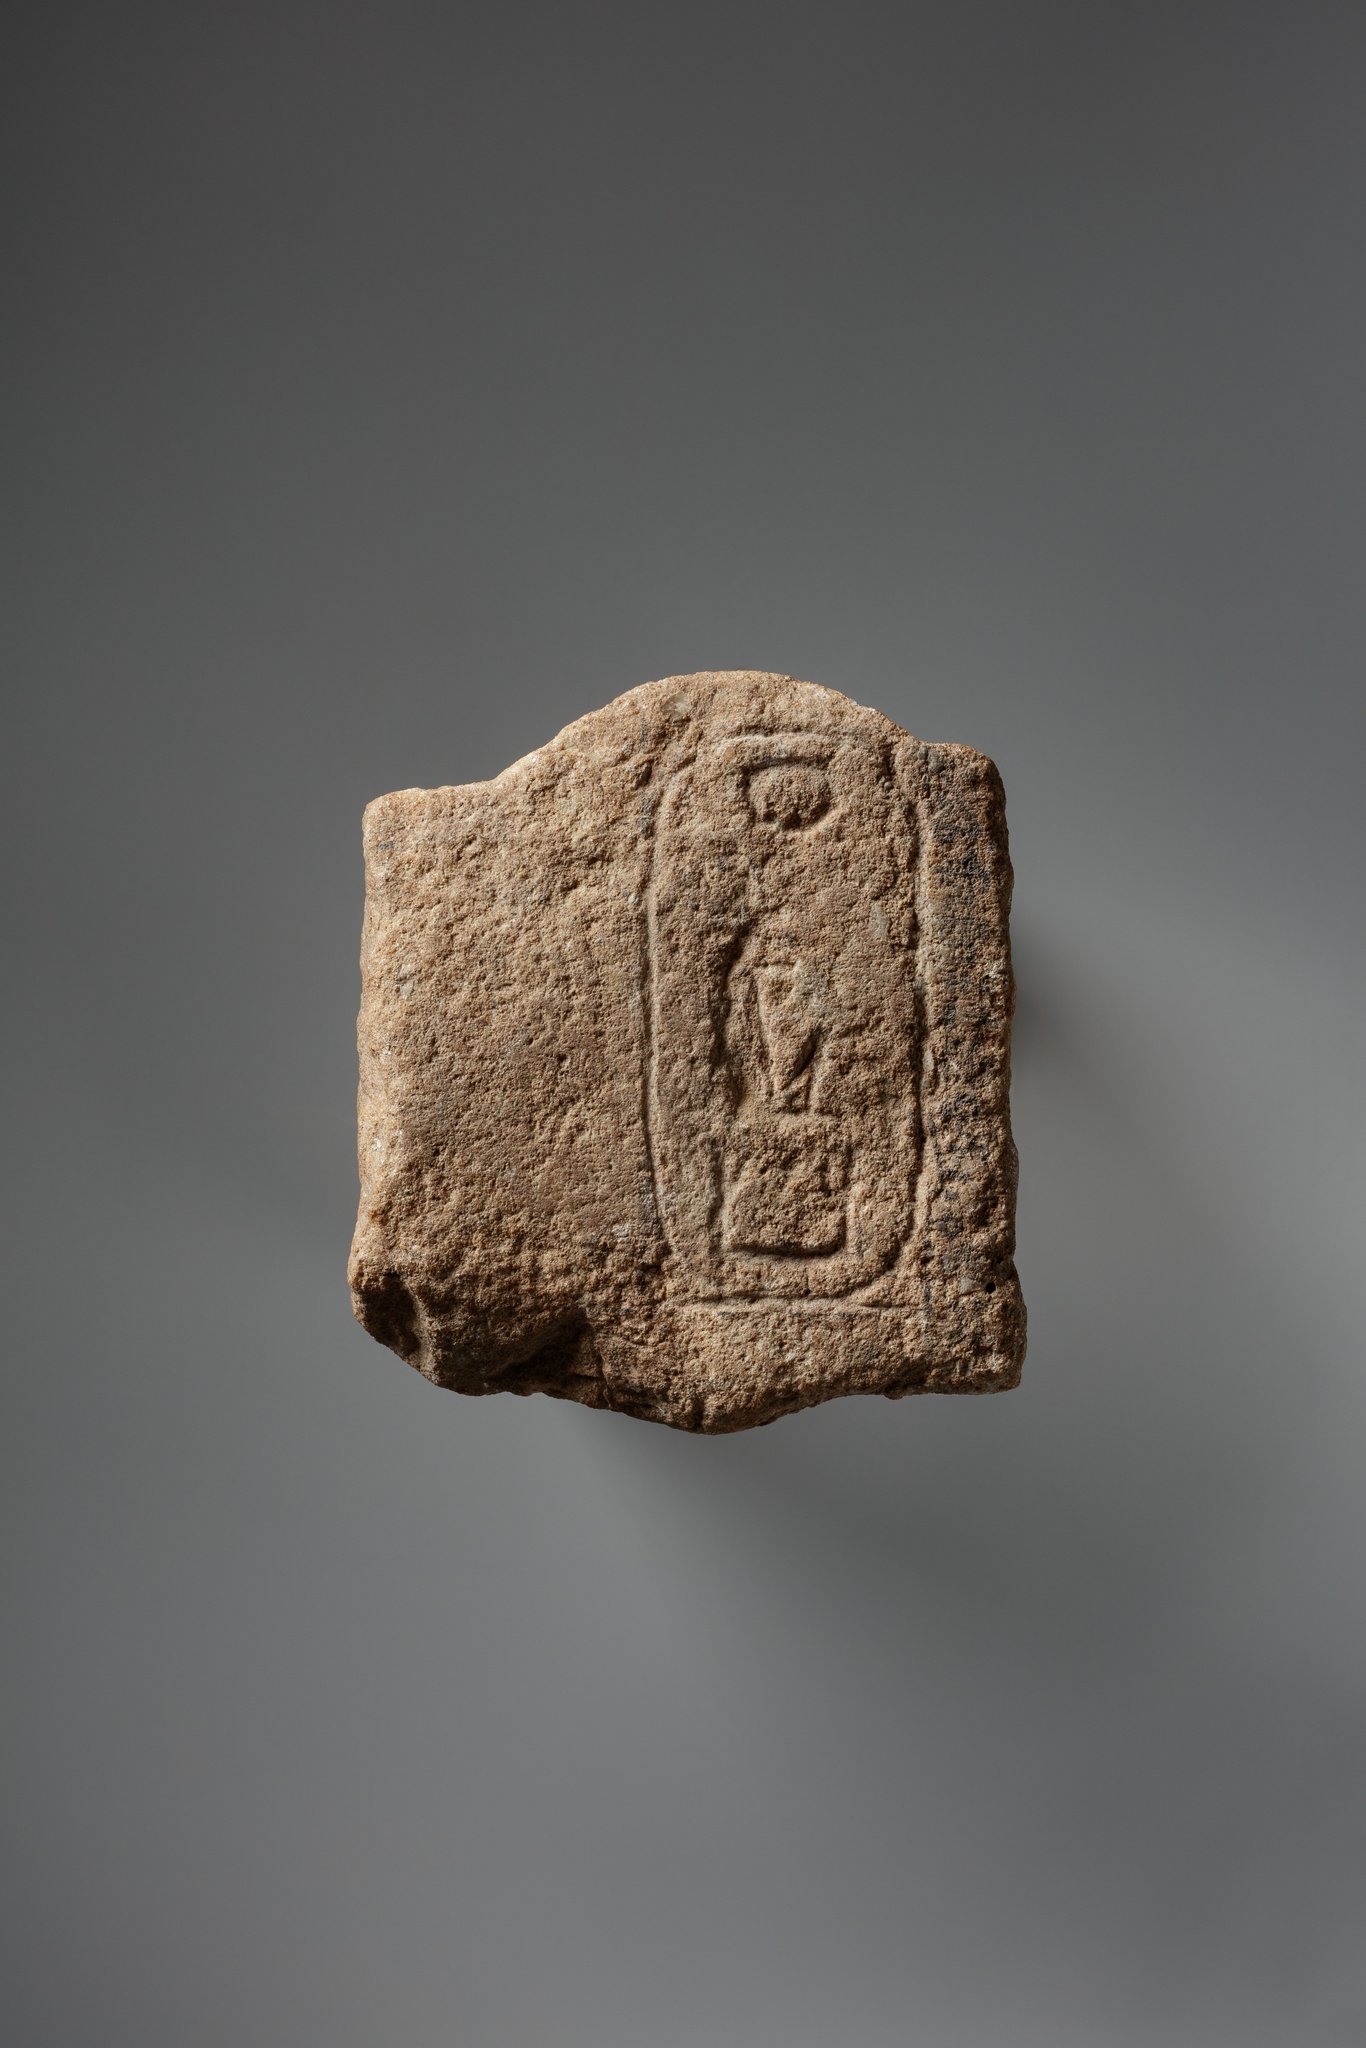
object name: inscribed stone, hatshepsut, maatkare, hieratic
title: Inscribed Stone from Hatshepsut's Valley Temple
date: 1479-1458 BCE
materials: ink, quartzite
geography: egypt